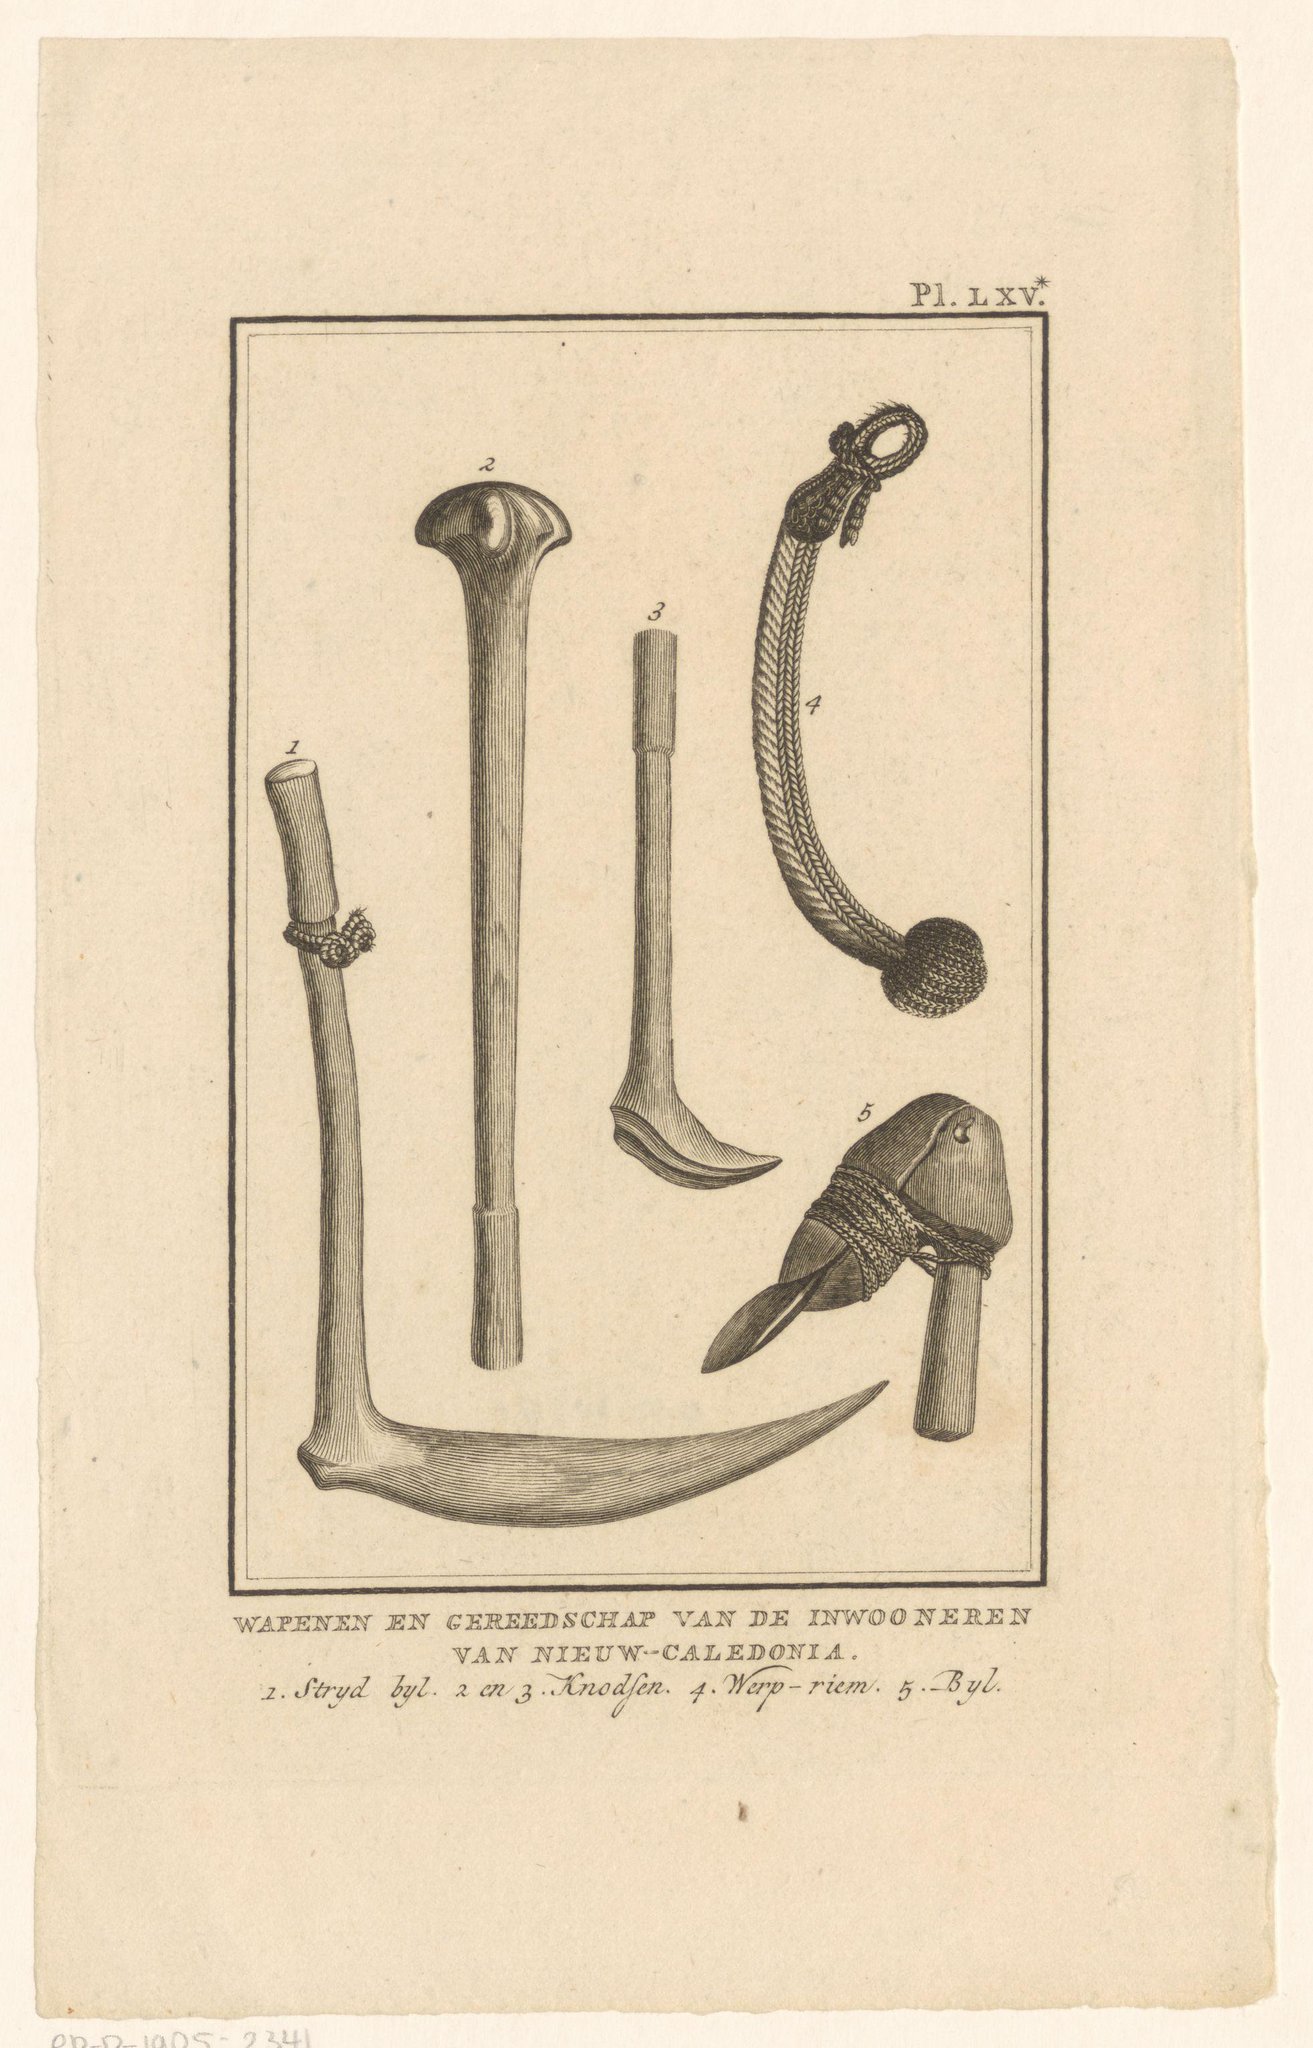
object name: book illustration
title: Wapens en gereedschap gemaakt door de oorspronkelijke bewoners van Nieuw-Caledonië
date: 1795-1803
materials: paper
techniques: engraving, etching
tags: hacking and thrusting weapons, helved weapons, polearms (for striking, hacking, thrusting), casting weapons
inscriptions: number: ‘LXV’, collector's mark: Lugt 2228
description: De prent is gebruikt in: Cook, James. Reize rondom de Waereld (...) met kaarten en plaaten. [Vertaald uit het Engels door] Jan David Pasteur. Leiden: Honkoop, Amsterdam: Allart, Den Haag: Van Cleef, 1795-1803, dl. 13.